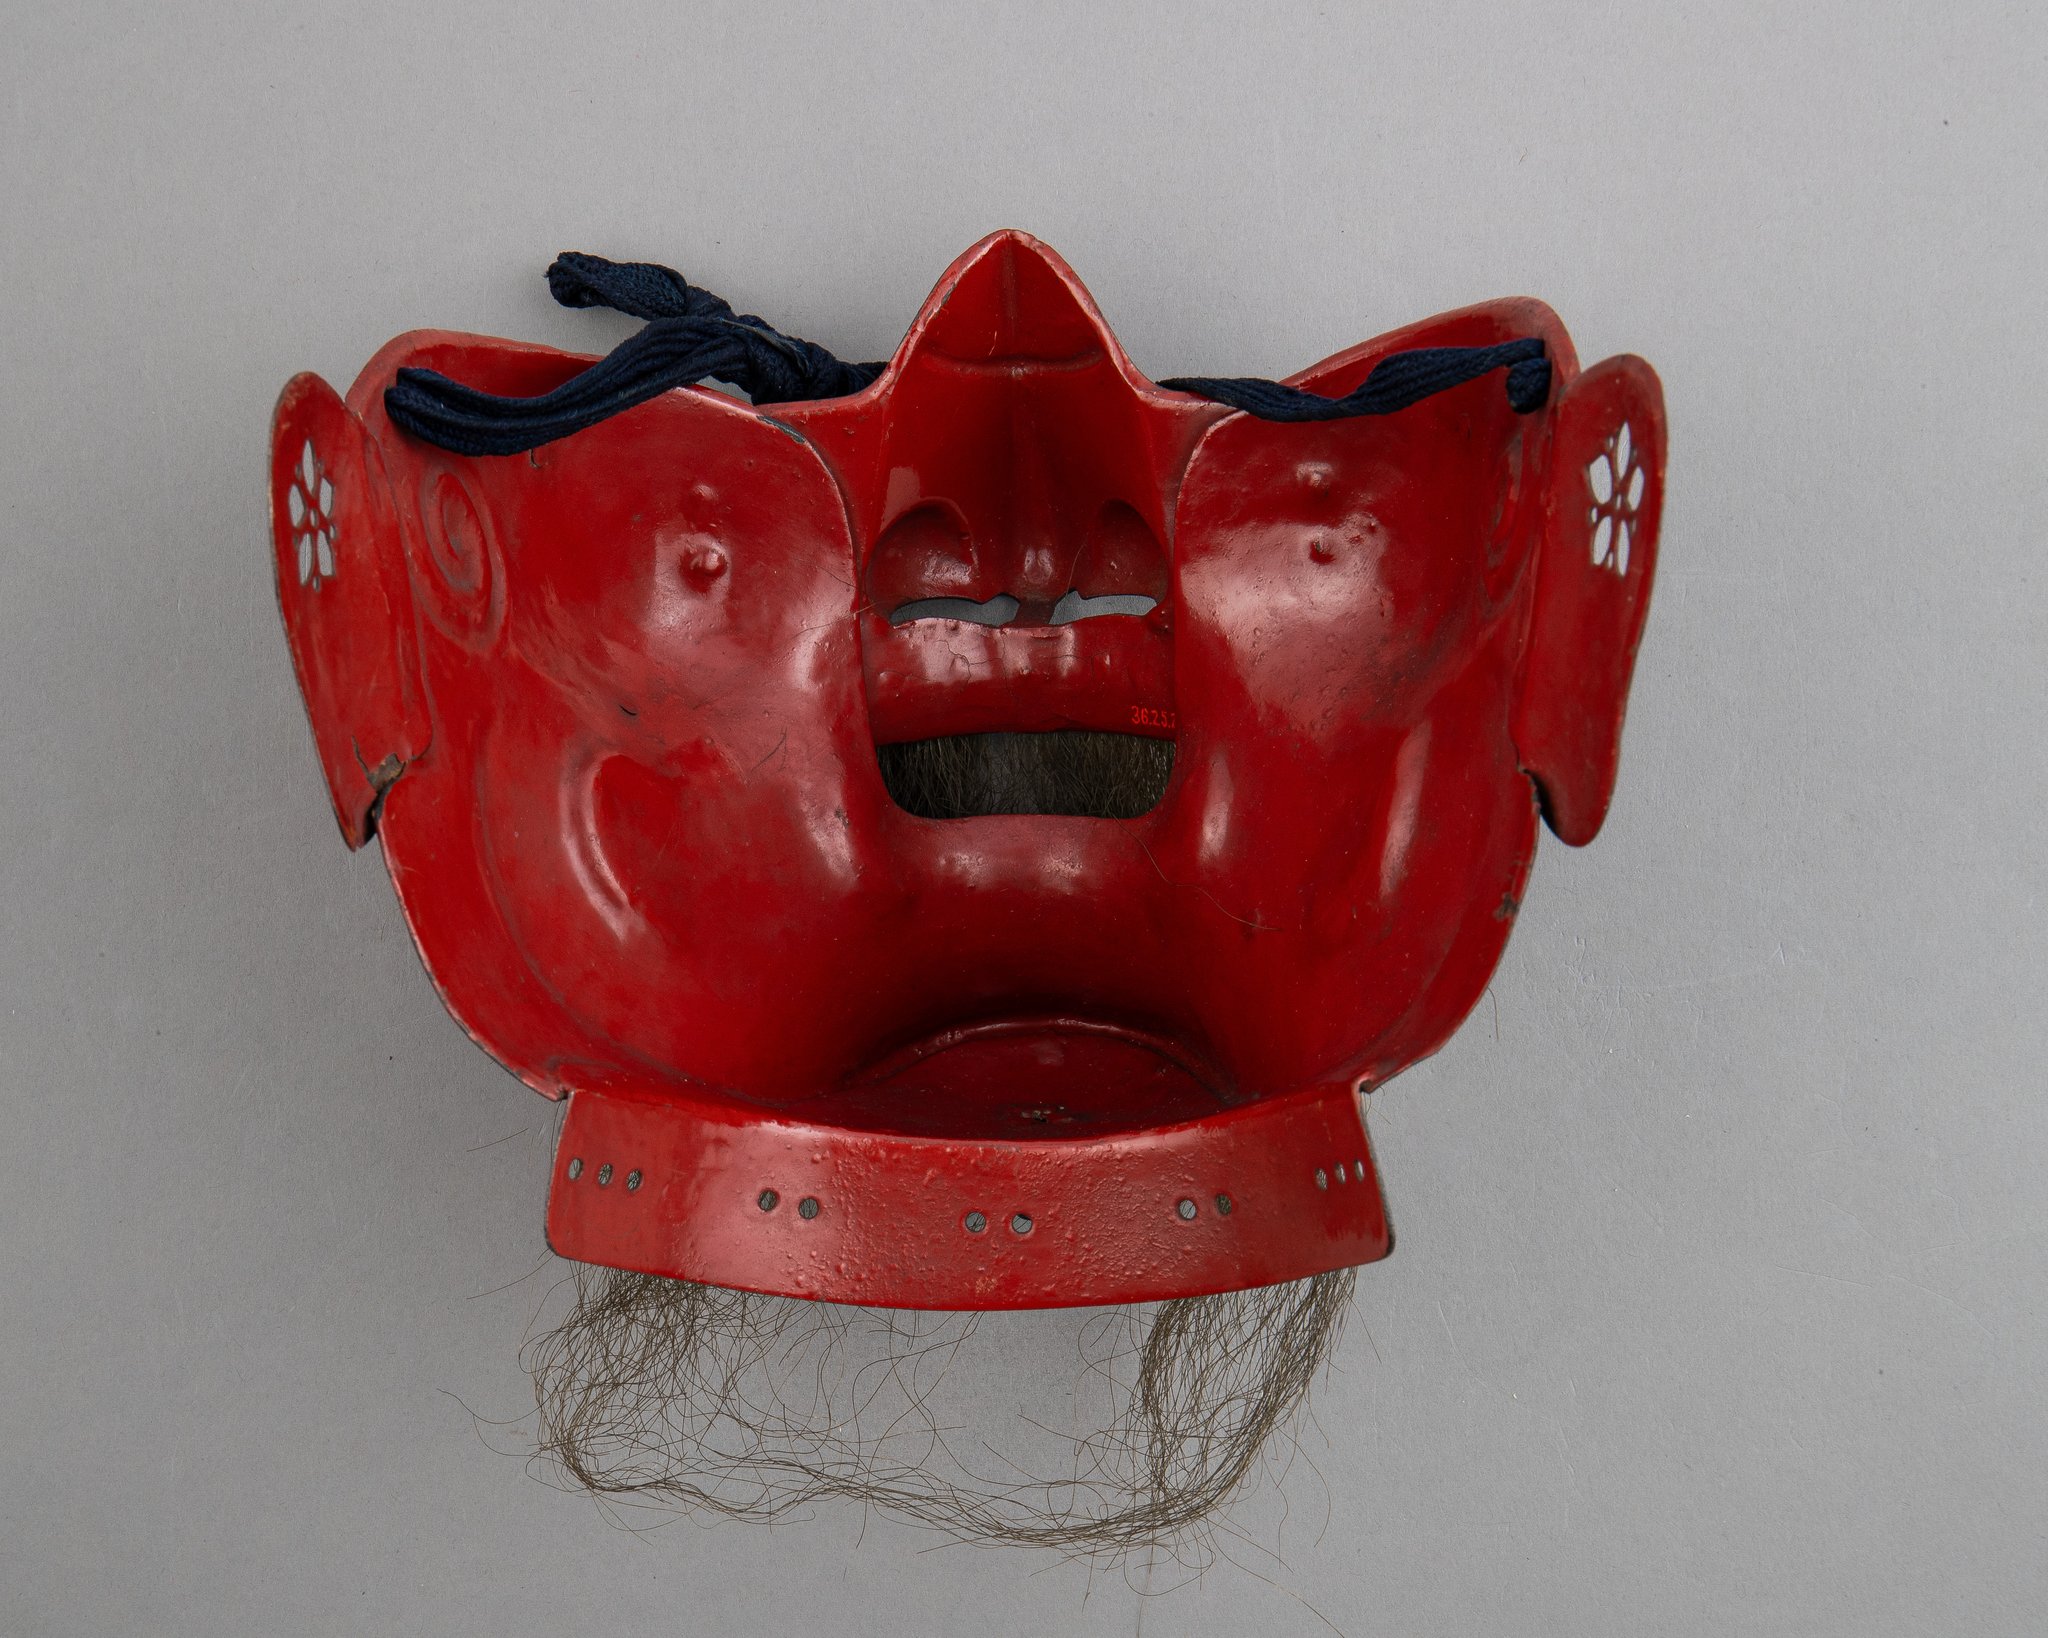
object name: half mask menpō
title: Half Mask (Menpō)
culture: japanese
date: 1615-1868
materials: hair, iron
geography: japan